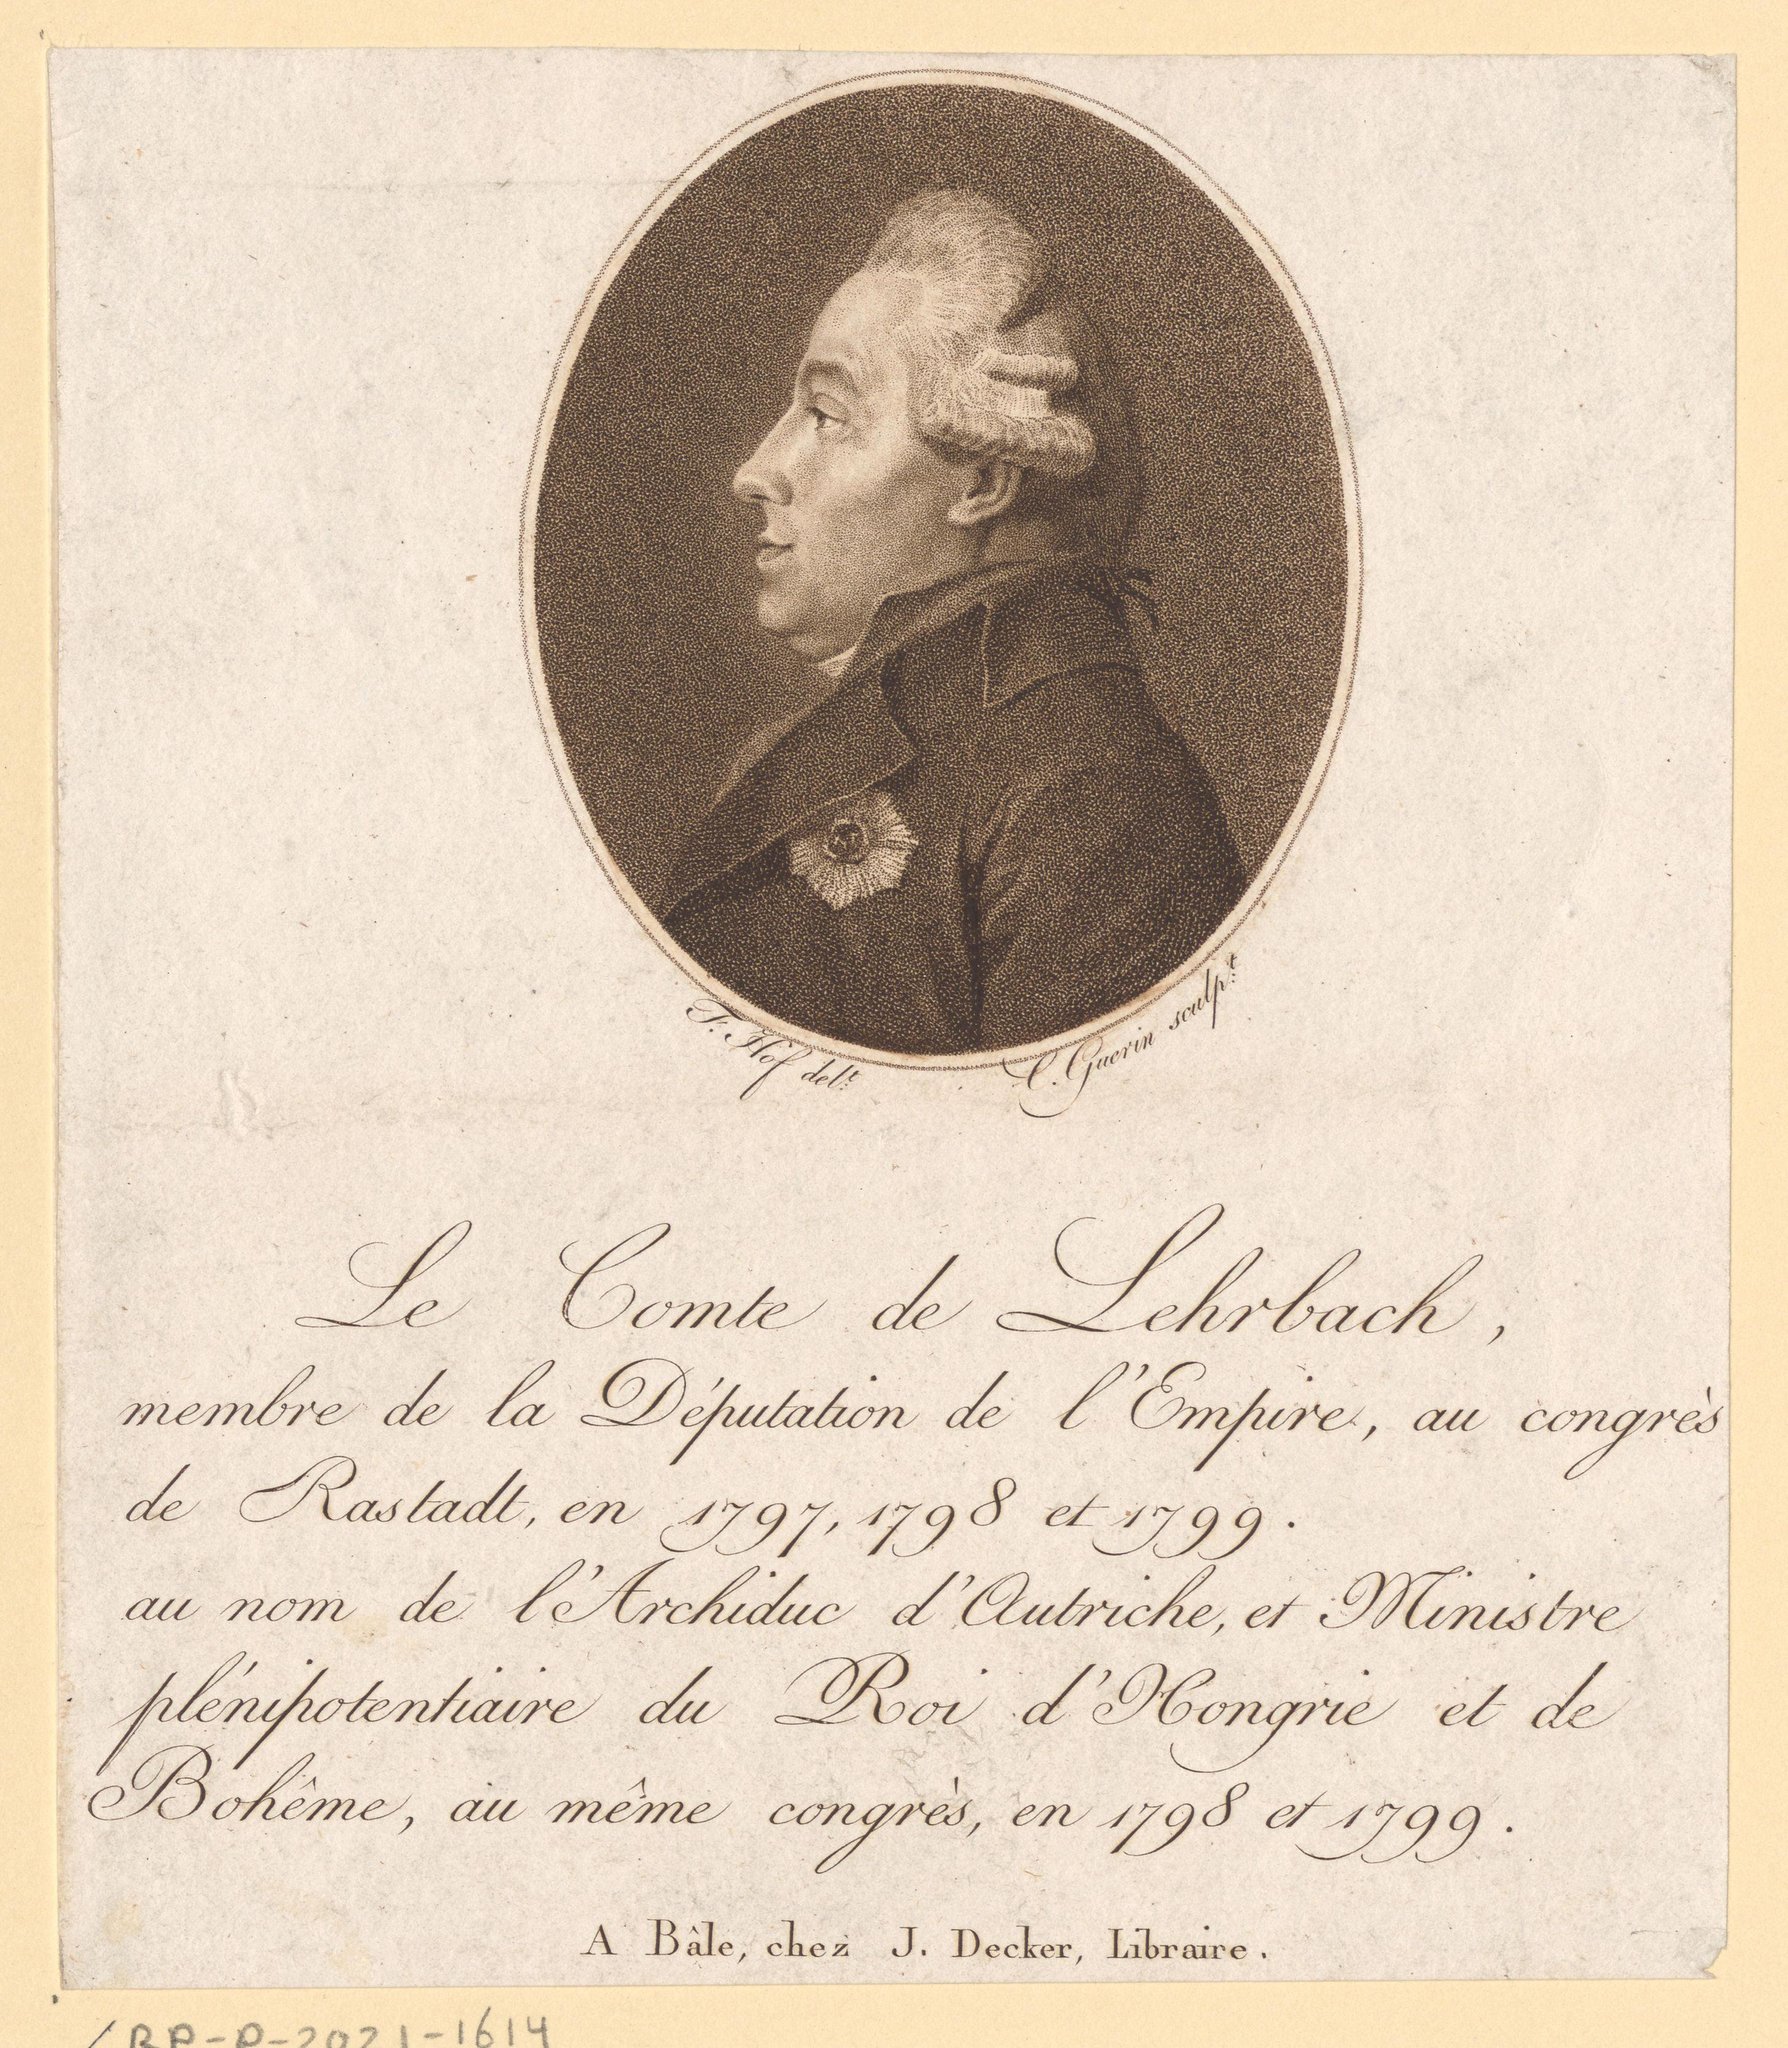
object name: print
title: Portret van Ludwig Conrad Lehrbach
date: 1799-1805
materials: paper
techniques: engraving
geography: basel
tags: historical persons, wig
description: Met zesregelig onderschrift in het Frans.